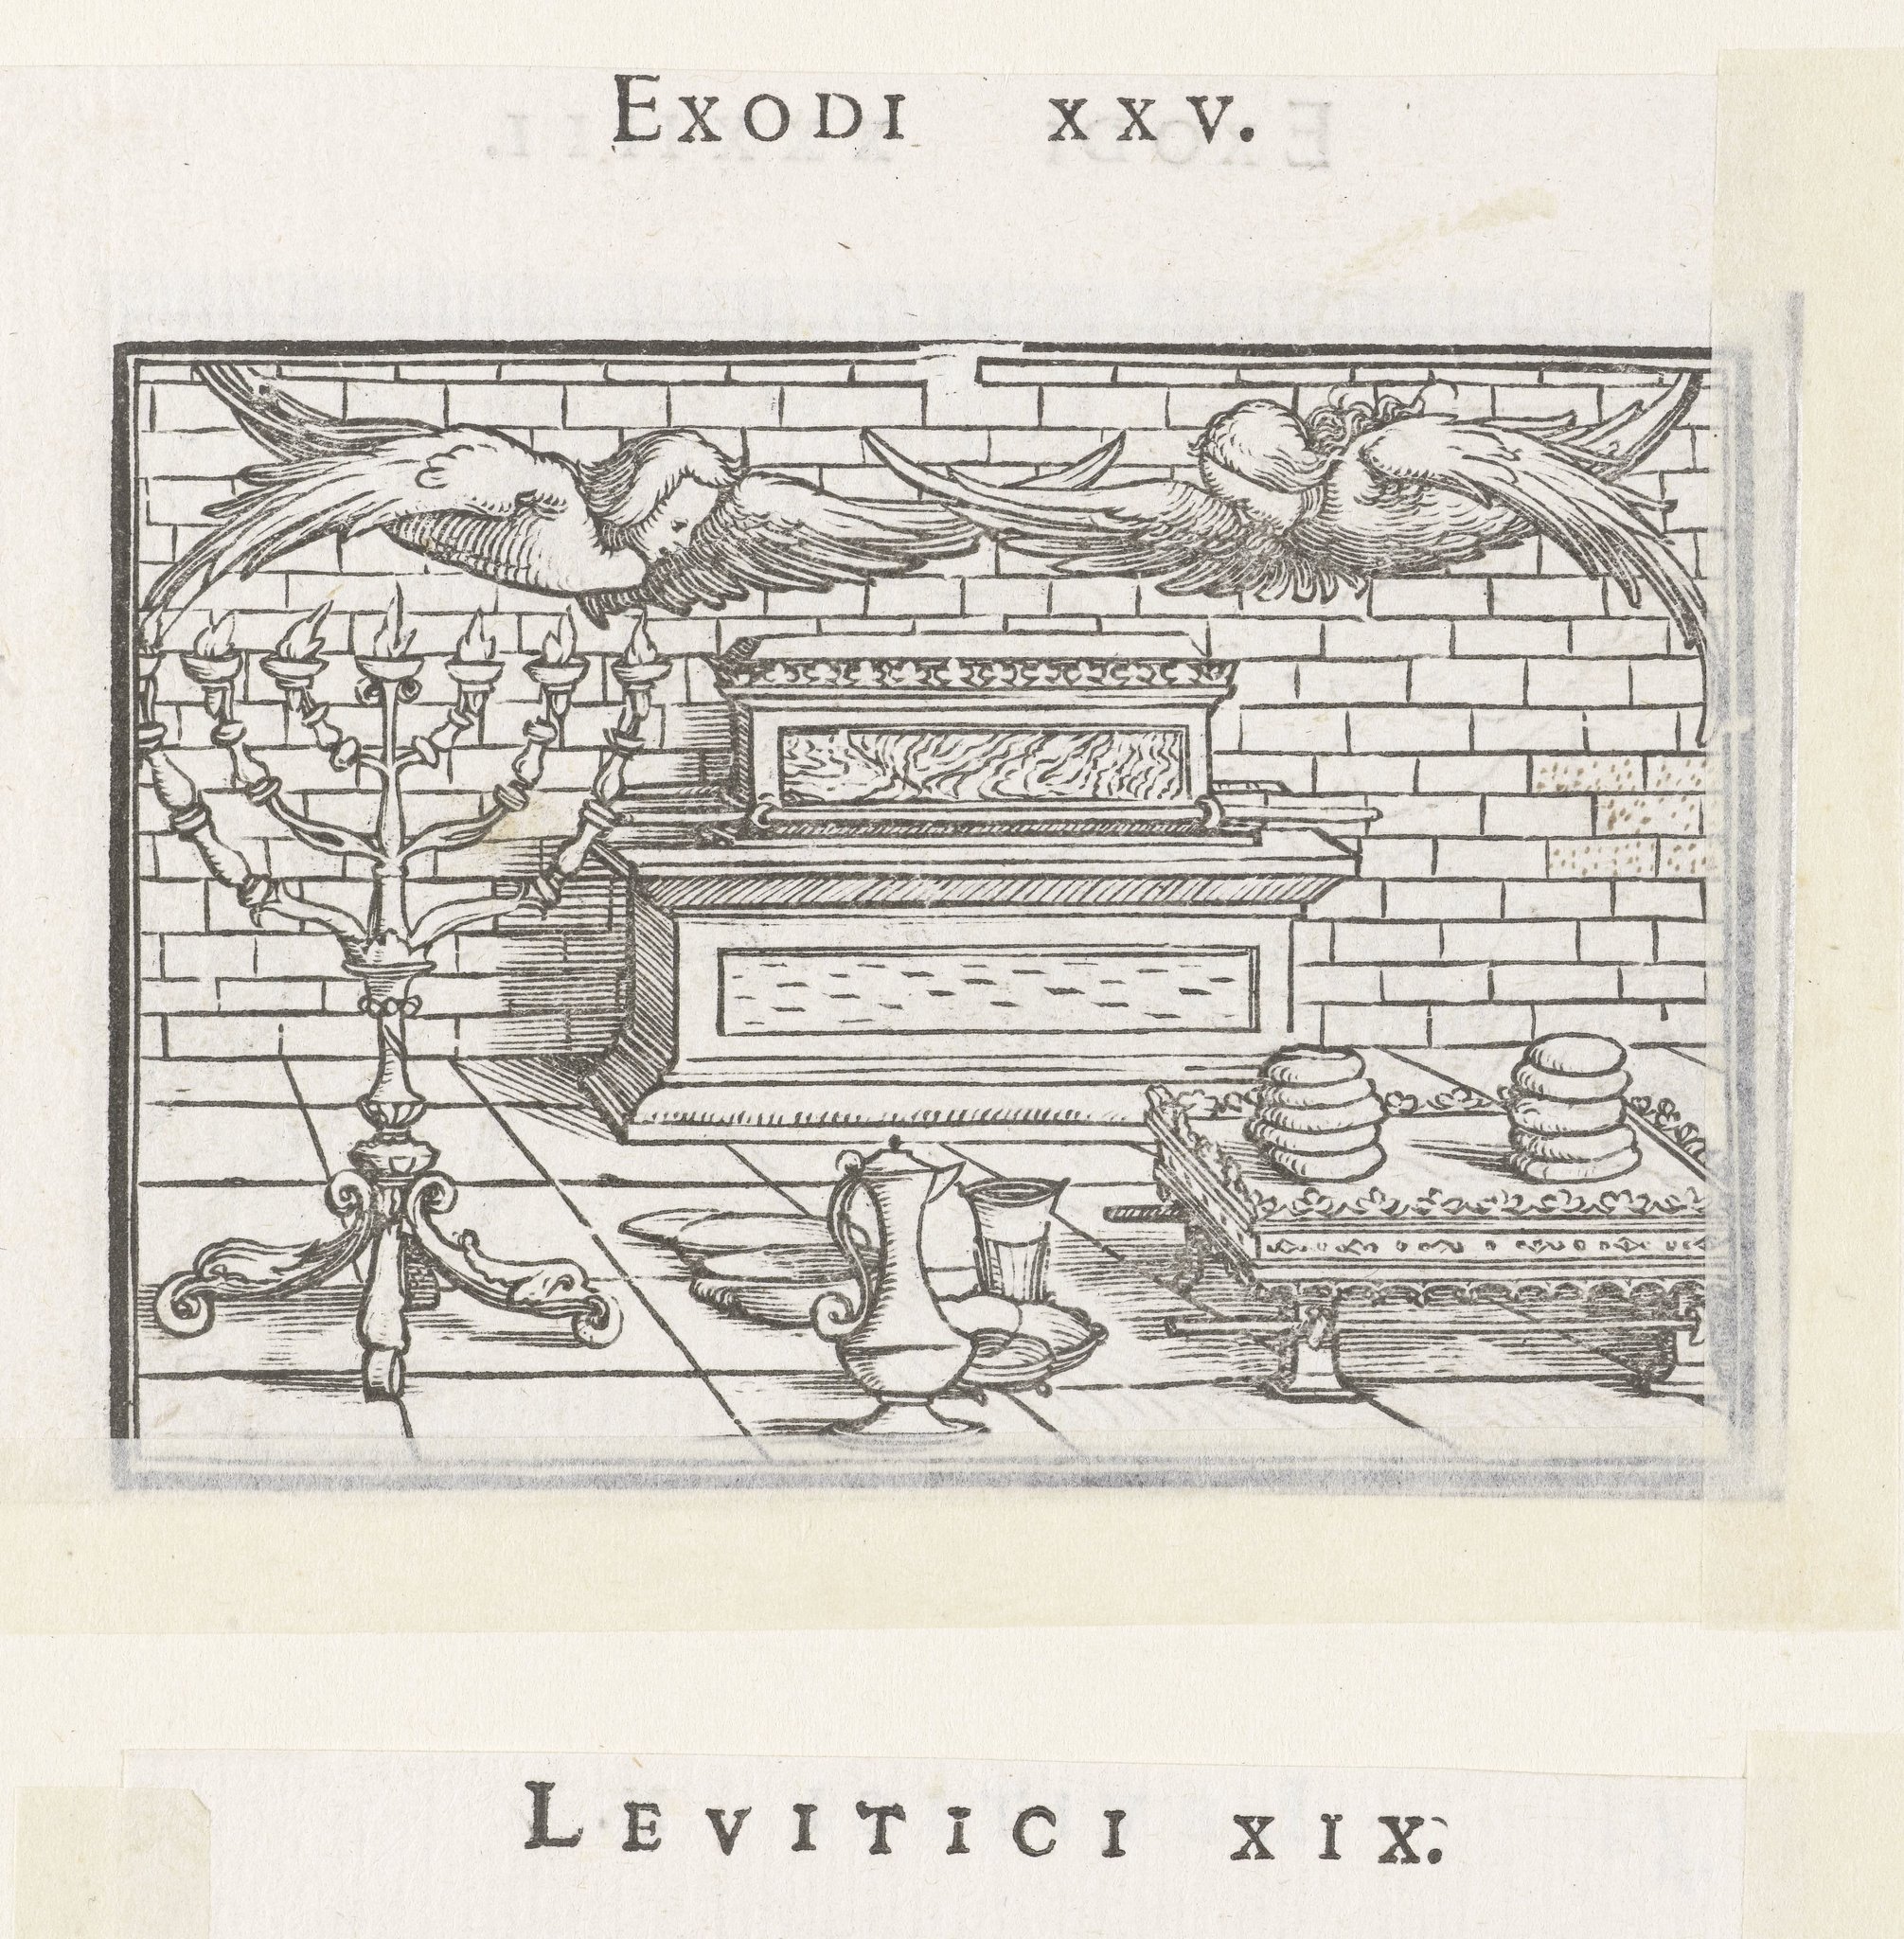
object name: book illustration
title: Ark van het verbond en voorwerpen uit de tabernakel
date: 1538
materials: paper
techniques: woodcut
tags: other objects kept in the tabernacle, ark of the covenant ~ jewish religion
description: Ark van het verbond, waarin tafelen der wet worden bewaard, en andere voorwerpen die behoren tot de inrichting van de tabernakel. Links staat een menora, daarnaast vaatwerk voor de offers en rechts staat het toonbrood, boven de voorwerpen zweven twee cherubijnen. In de marge boven de afbeelding staat de tekst Exodi XXV.